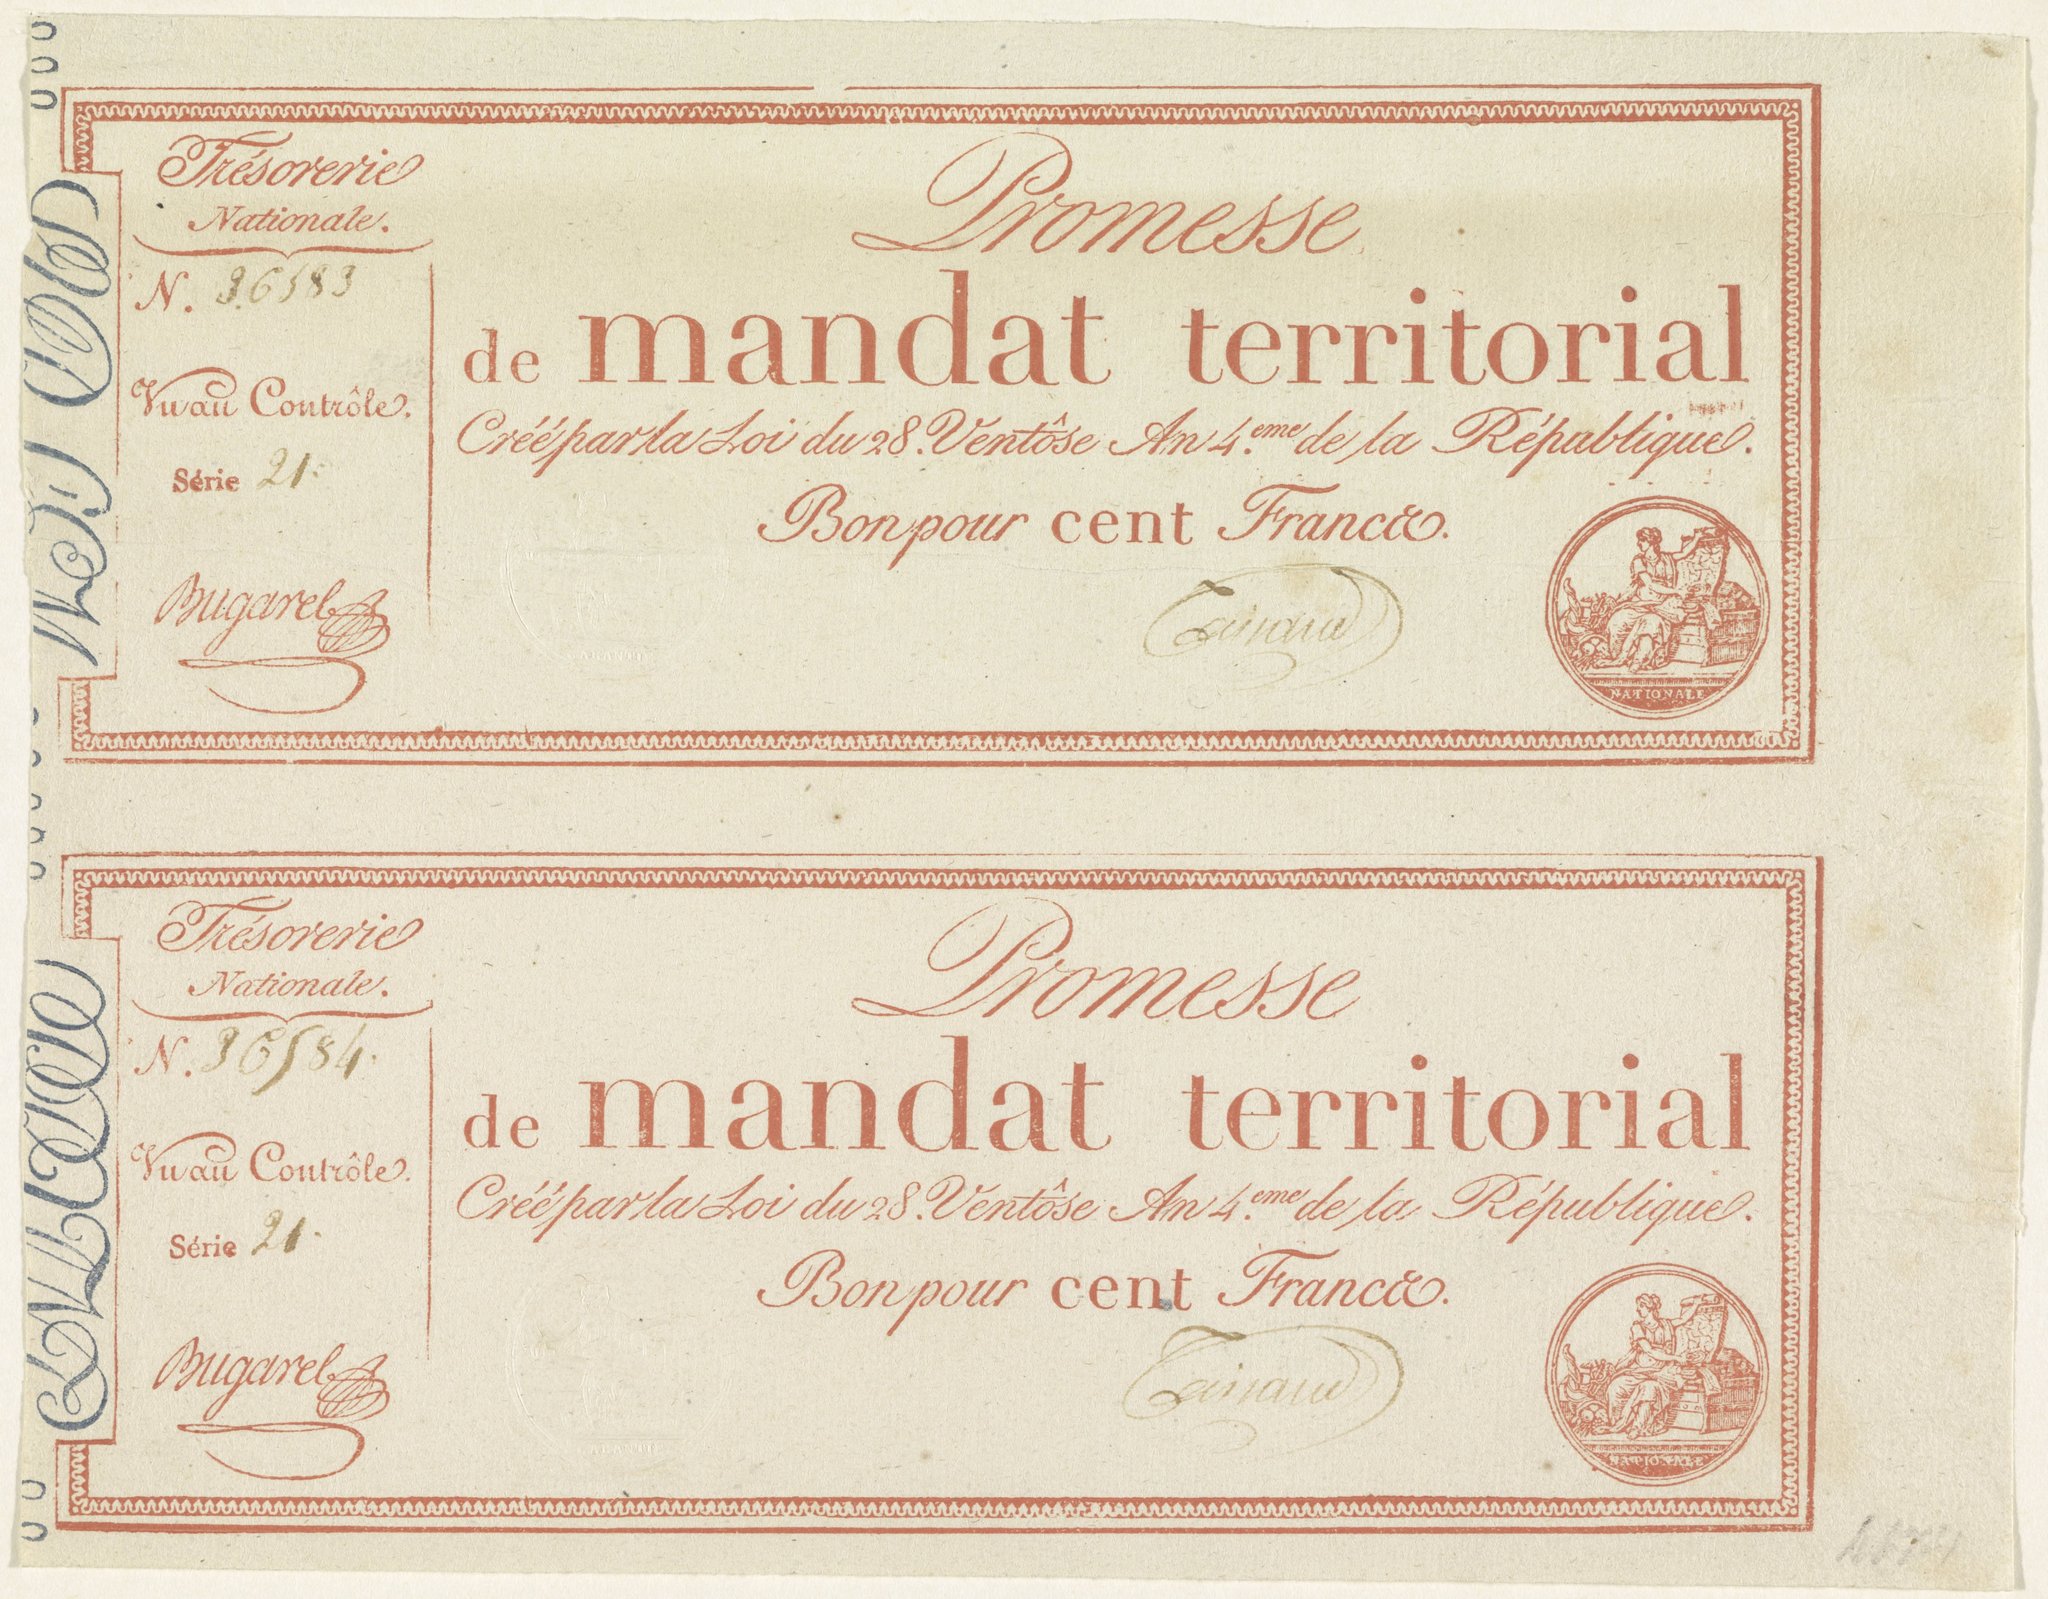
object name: print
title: Twee promessen van 100 frank, 1795-1796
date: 1795-1796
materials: paper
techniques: blind stamped, printing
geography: france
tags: bank-note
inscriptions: collector's mark: Lugt 2228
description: Twee Franse promessen ter waarde van 100 frank. In omloop gebracht door de Trésorie nationale, serie 21, 1795-1796, met handtekening.